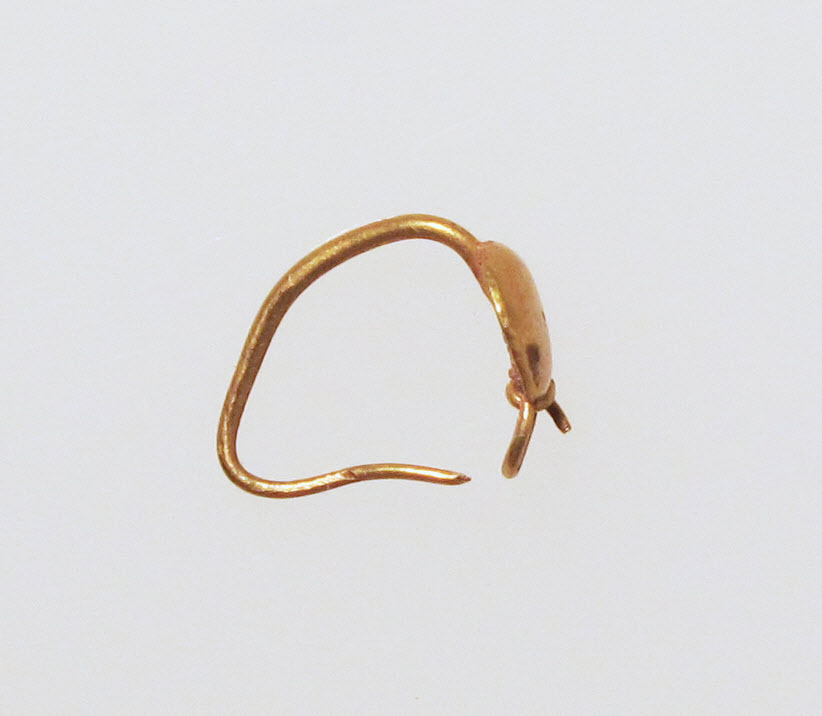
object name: earring with plain loop and disc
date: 7000 BCE-330 CE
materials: gold